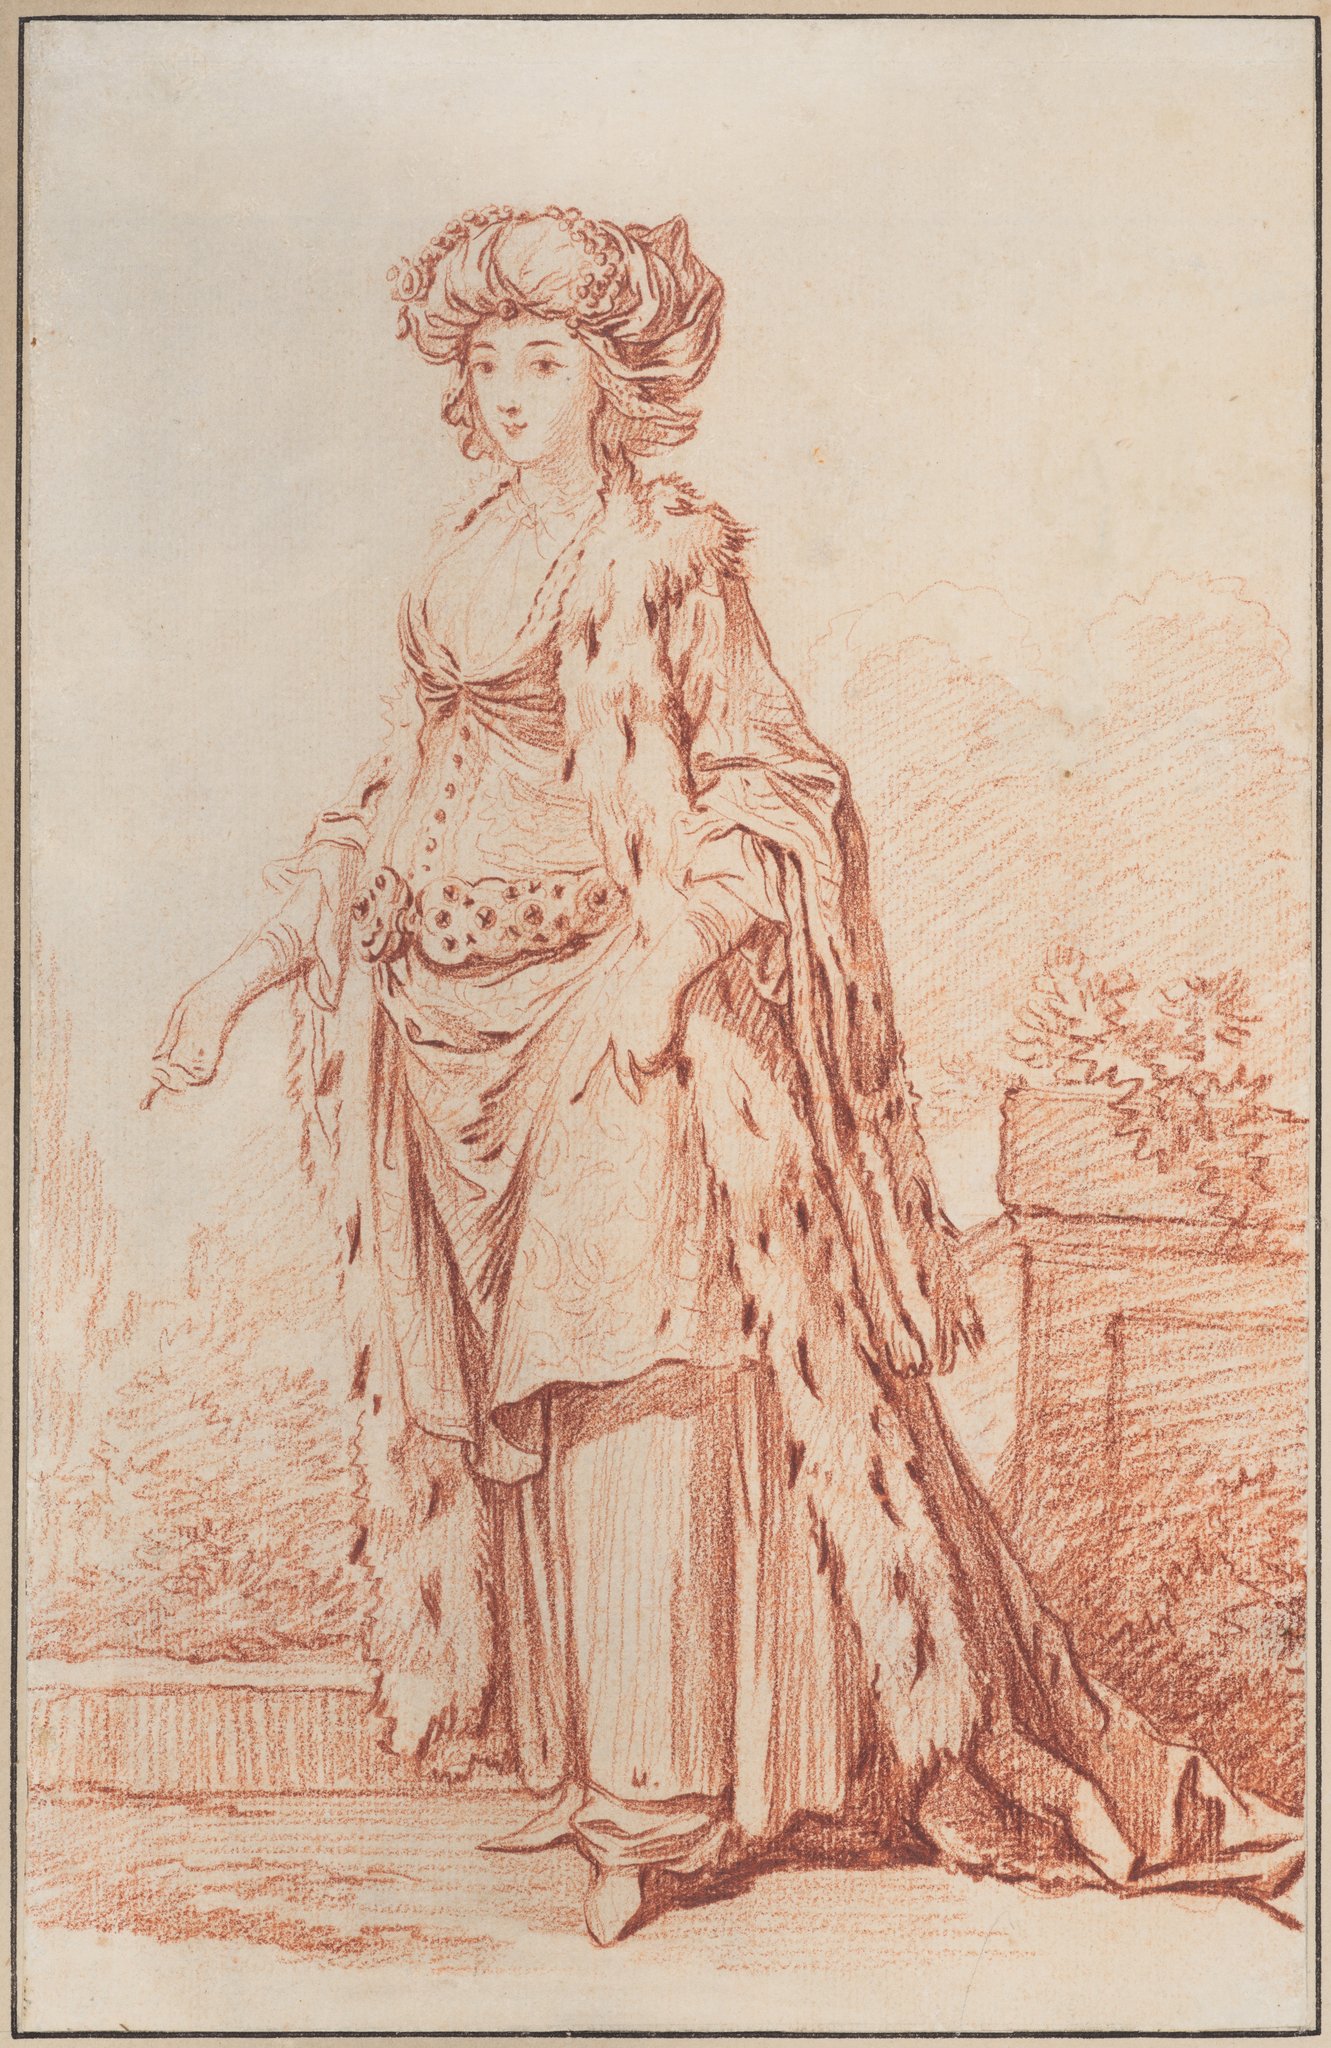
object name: drawing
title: Woman of Constantinople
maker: françois boucher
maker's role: artist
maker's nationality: french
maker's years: 1703-1770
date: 1730-1731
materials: chalk